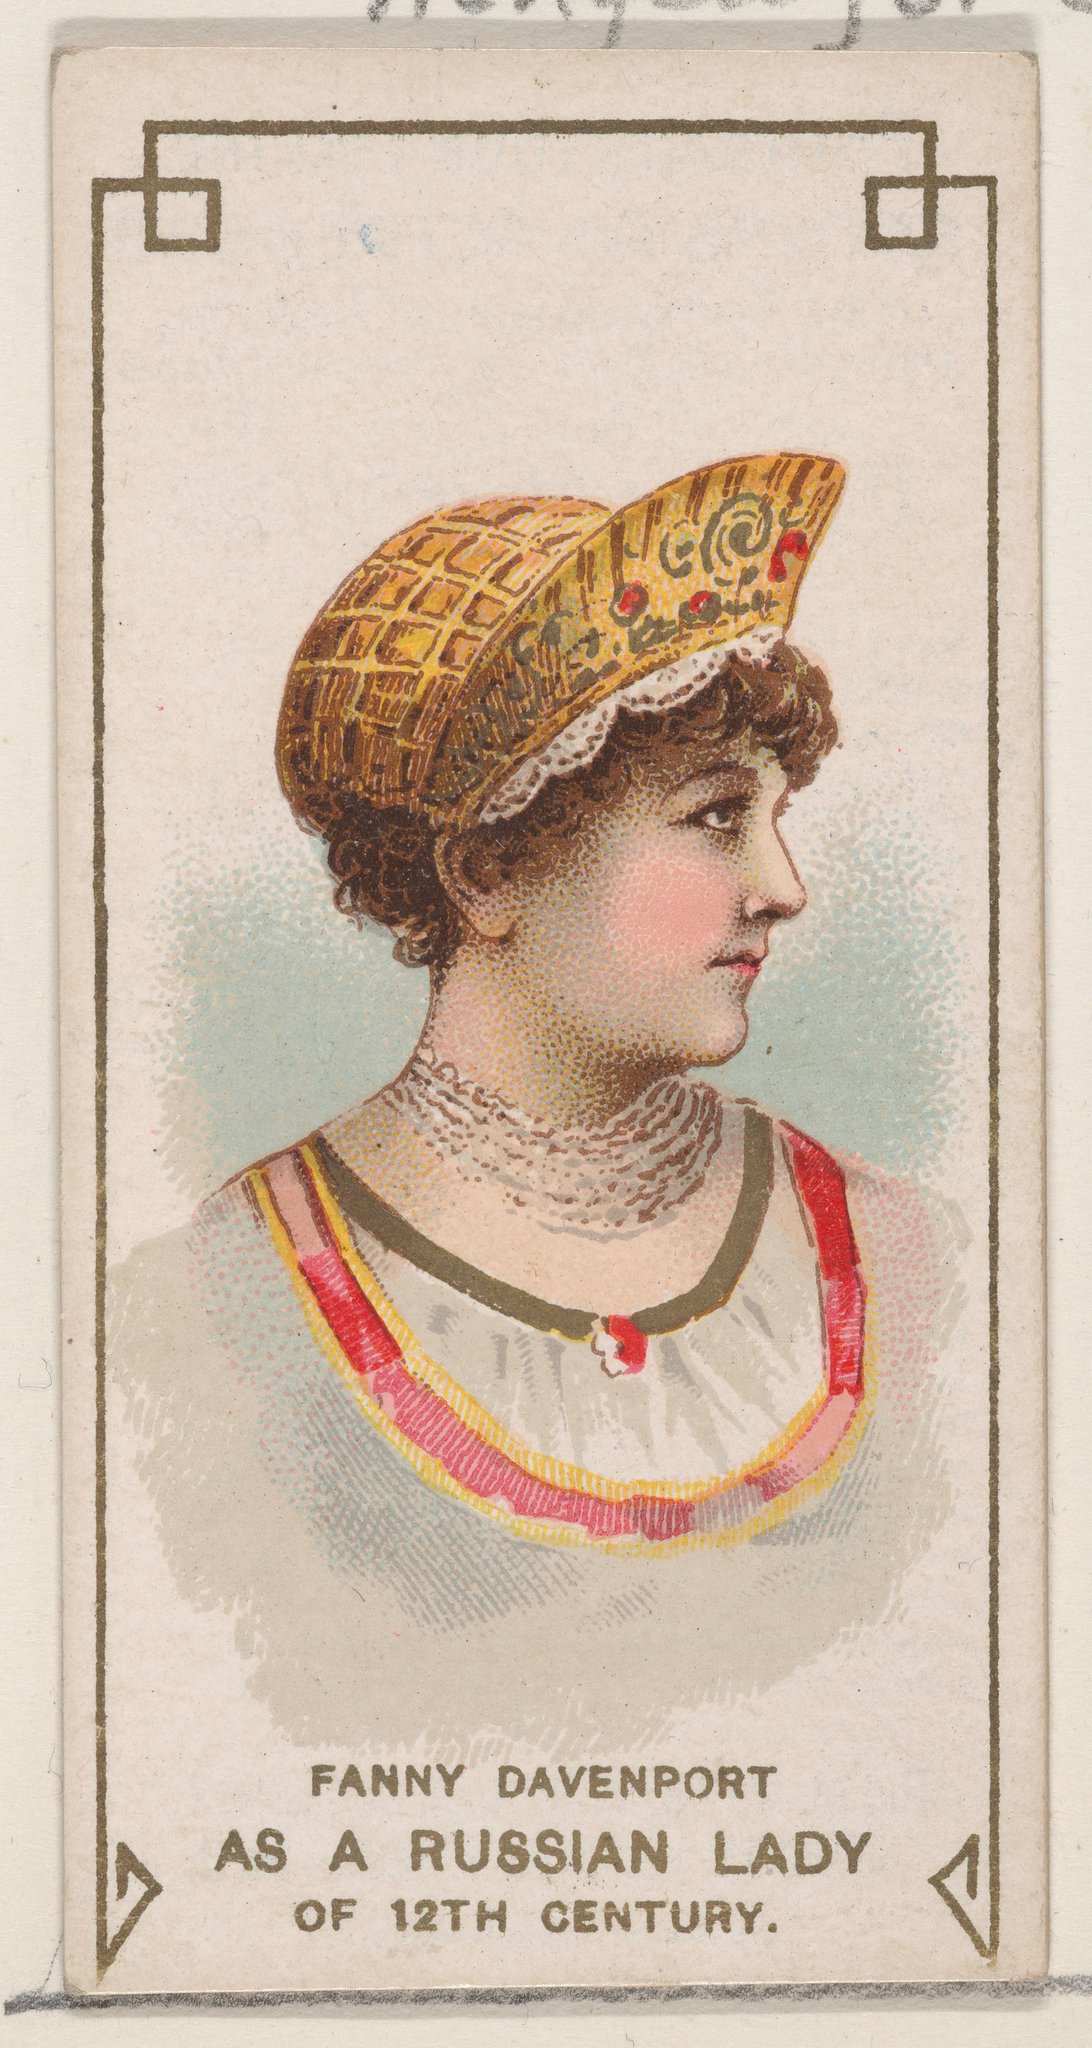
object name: print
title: Fanny Davenport as a Russian Lady of the 12th Century, from the set Actors and Actresses, First Series (N70) for Duke brand cigarettes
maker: w. duke, sons & co.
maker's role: publisher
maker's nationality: american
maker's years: 1870-1920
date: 1888-1889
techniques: color lithograph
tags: women,actresses